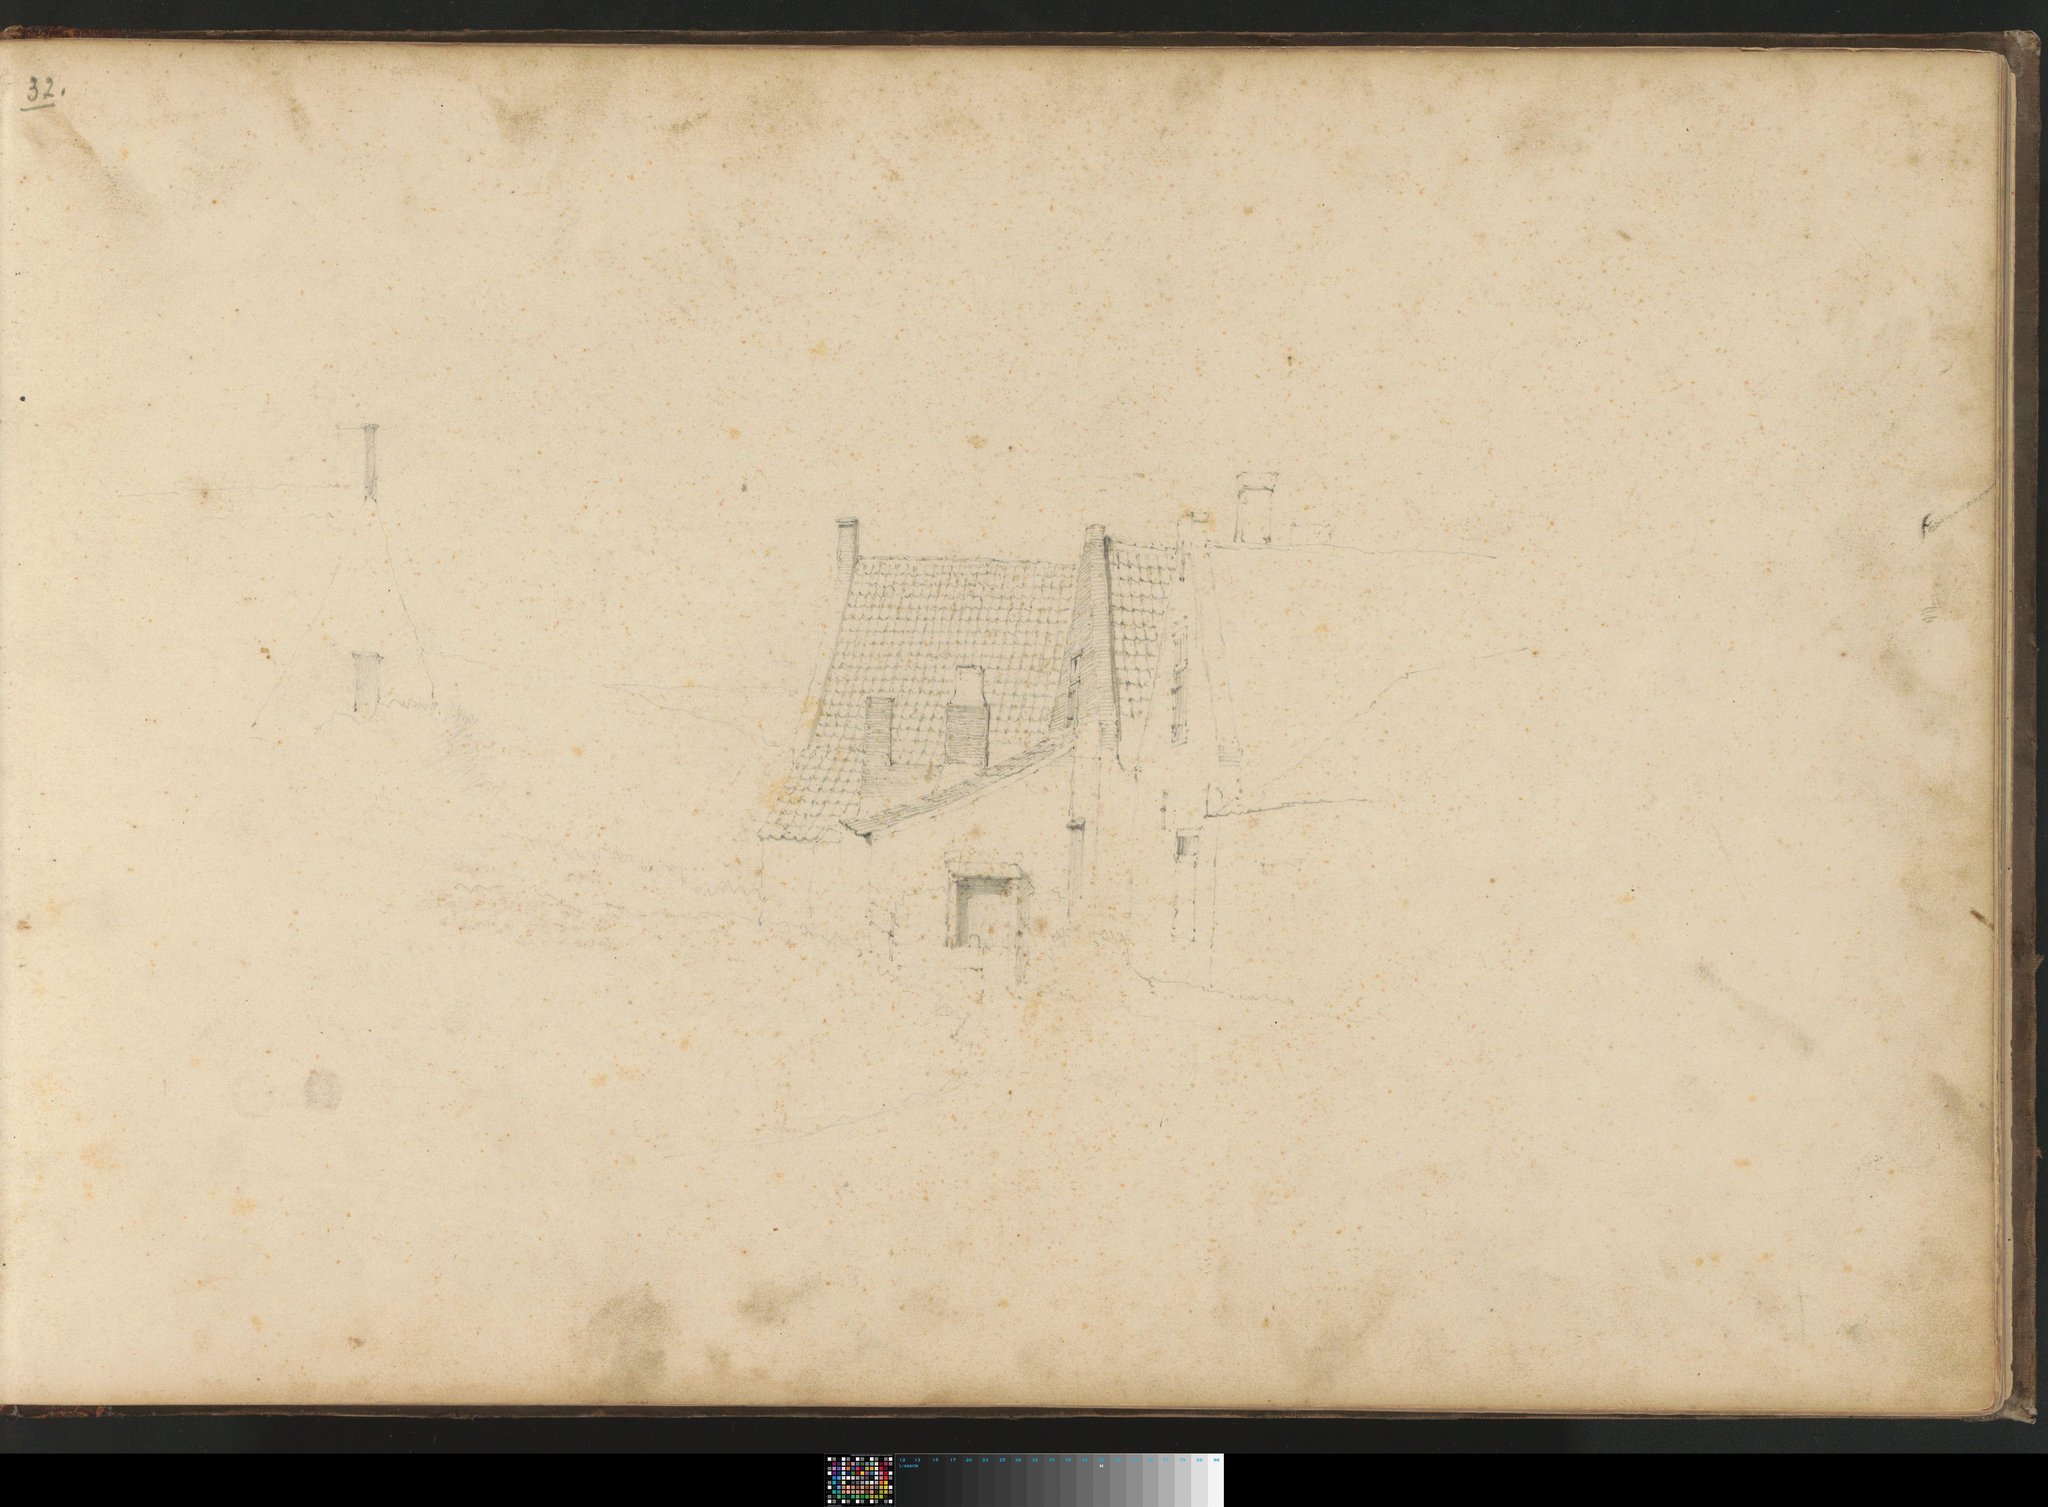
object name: sketchbook leaf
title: Rijtjeshuizen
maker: kasparus karsen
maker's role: draughtsman, painter, print maker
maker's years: 1810-1896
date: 1820-1896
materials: paper, pencil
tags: the usual house or row of houses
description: Blad 32 recto uit een schetsboek met 68 bladen.